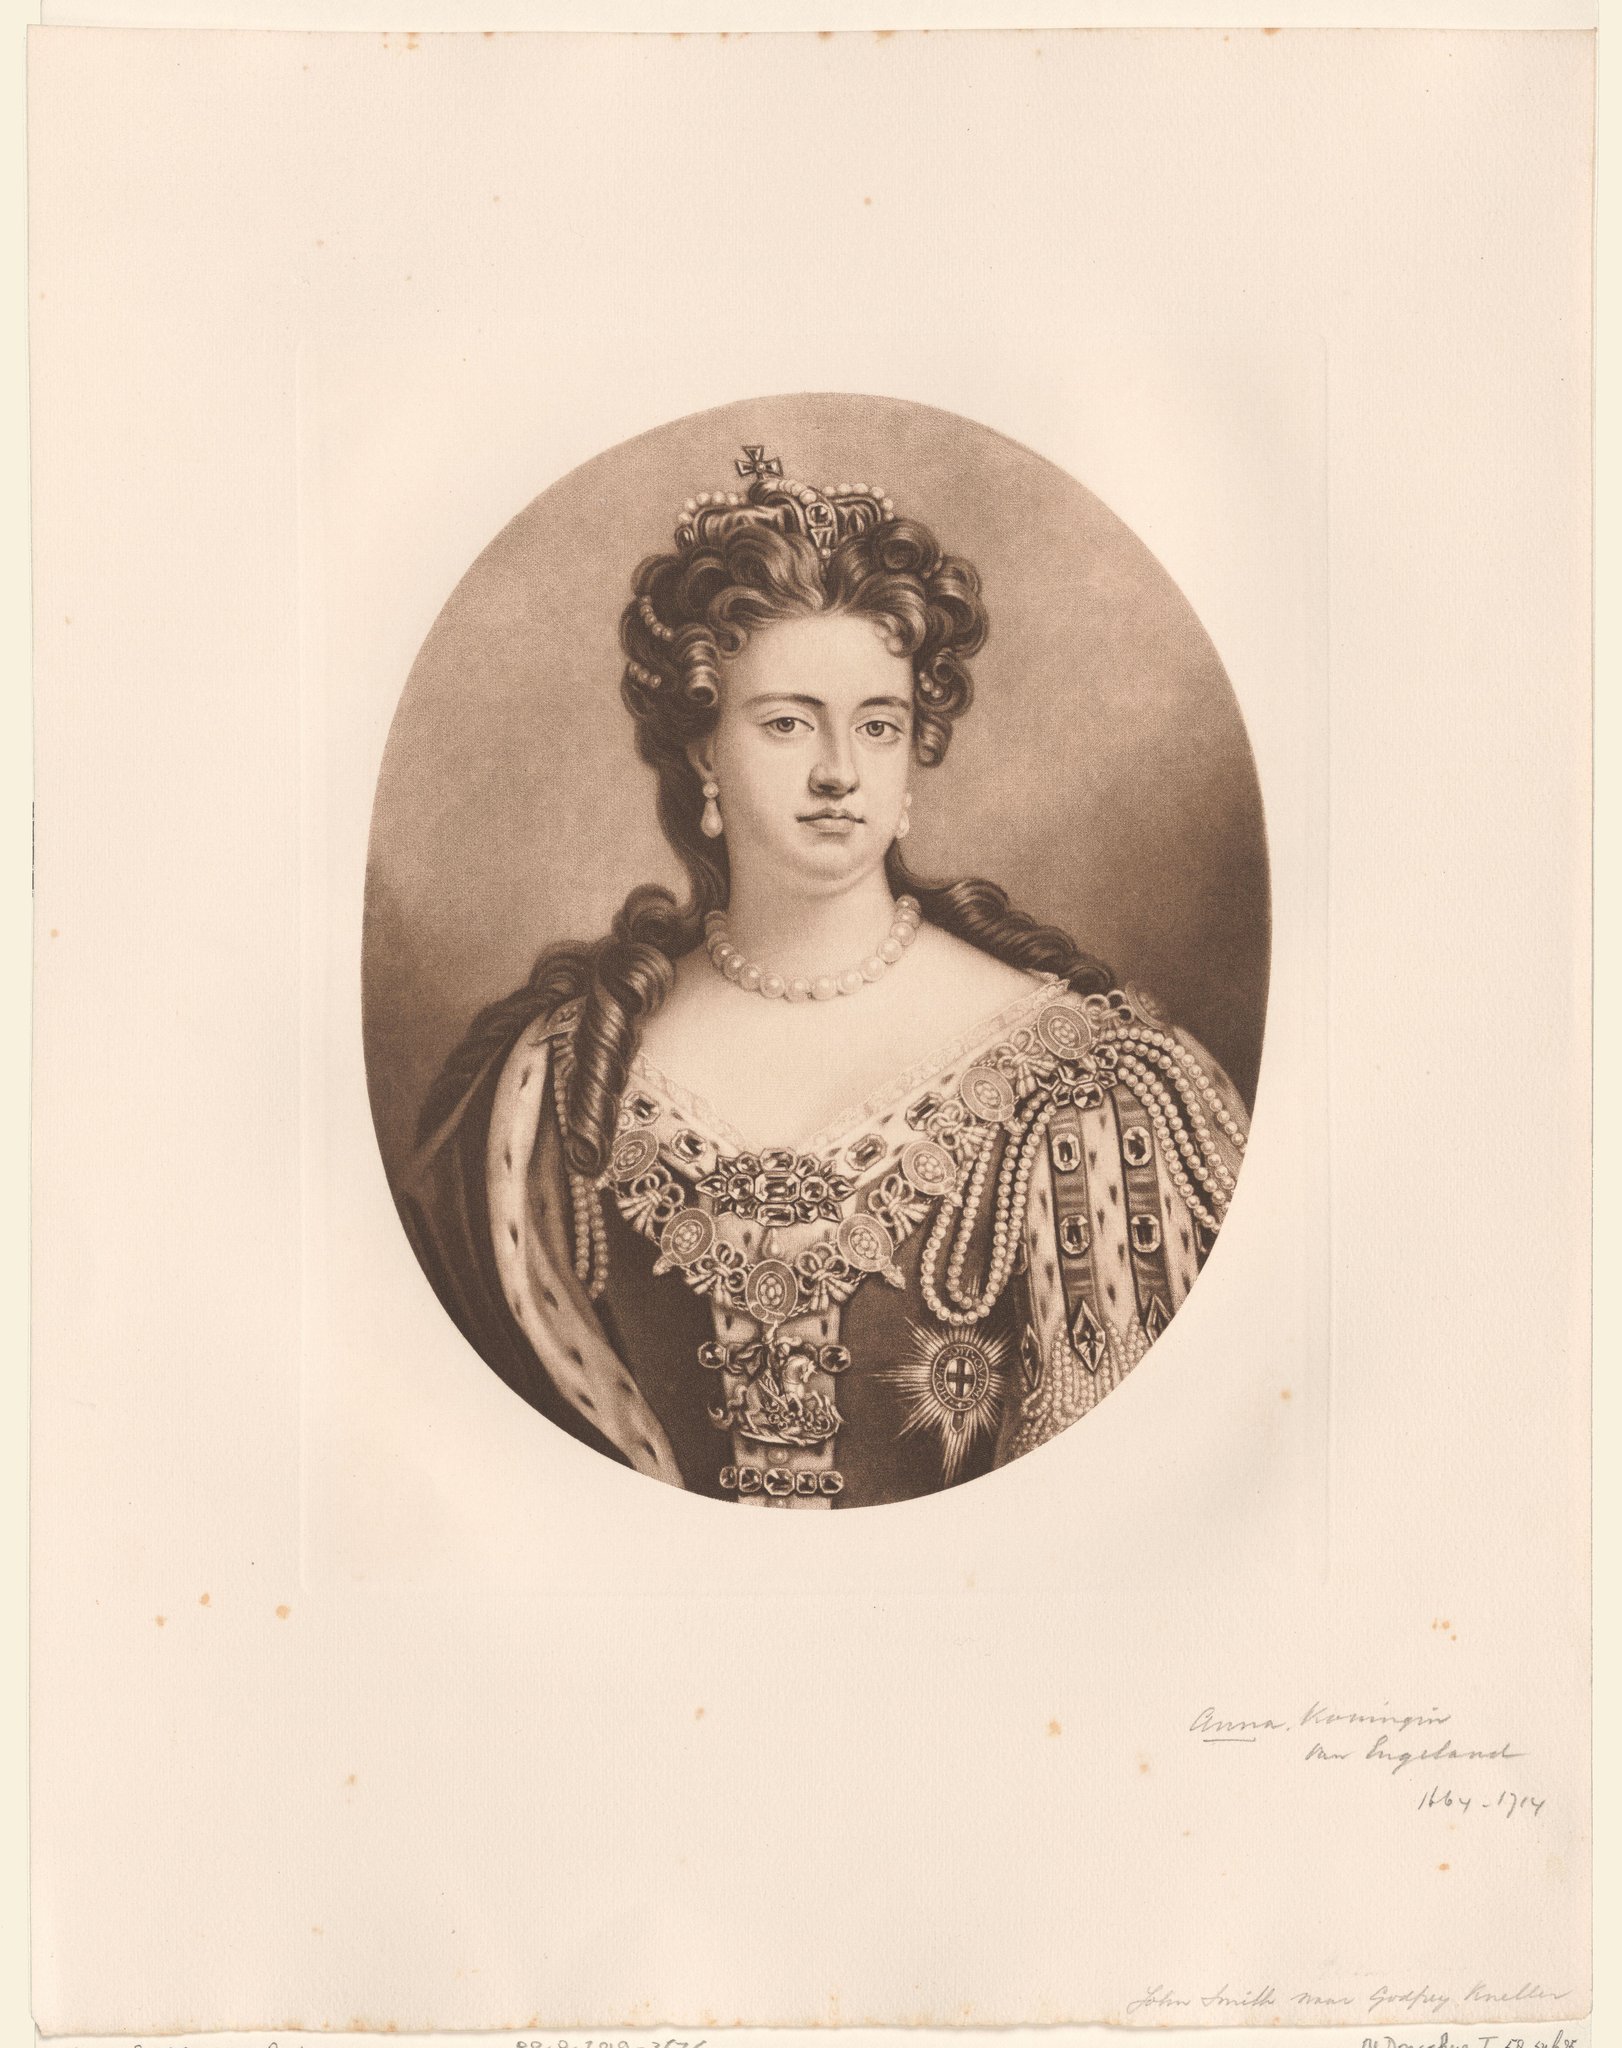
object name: photomechanical print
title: Portret van Anna Stuart, koningin van Groot-Brittannië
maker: Anonymous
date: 1850-1899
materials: paper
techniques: photoaquatint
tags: london, anna stuart (koningin van engeland en schotland), historical persons - bb - woman, insignia and symbols of sovereignty (crown, diadem, sceptre, orb, seal, standard, cloak, pectoral) - bb - female ruler